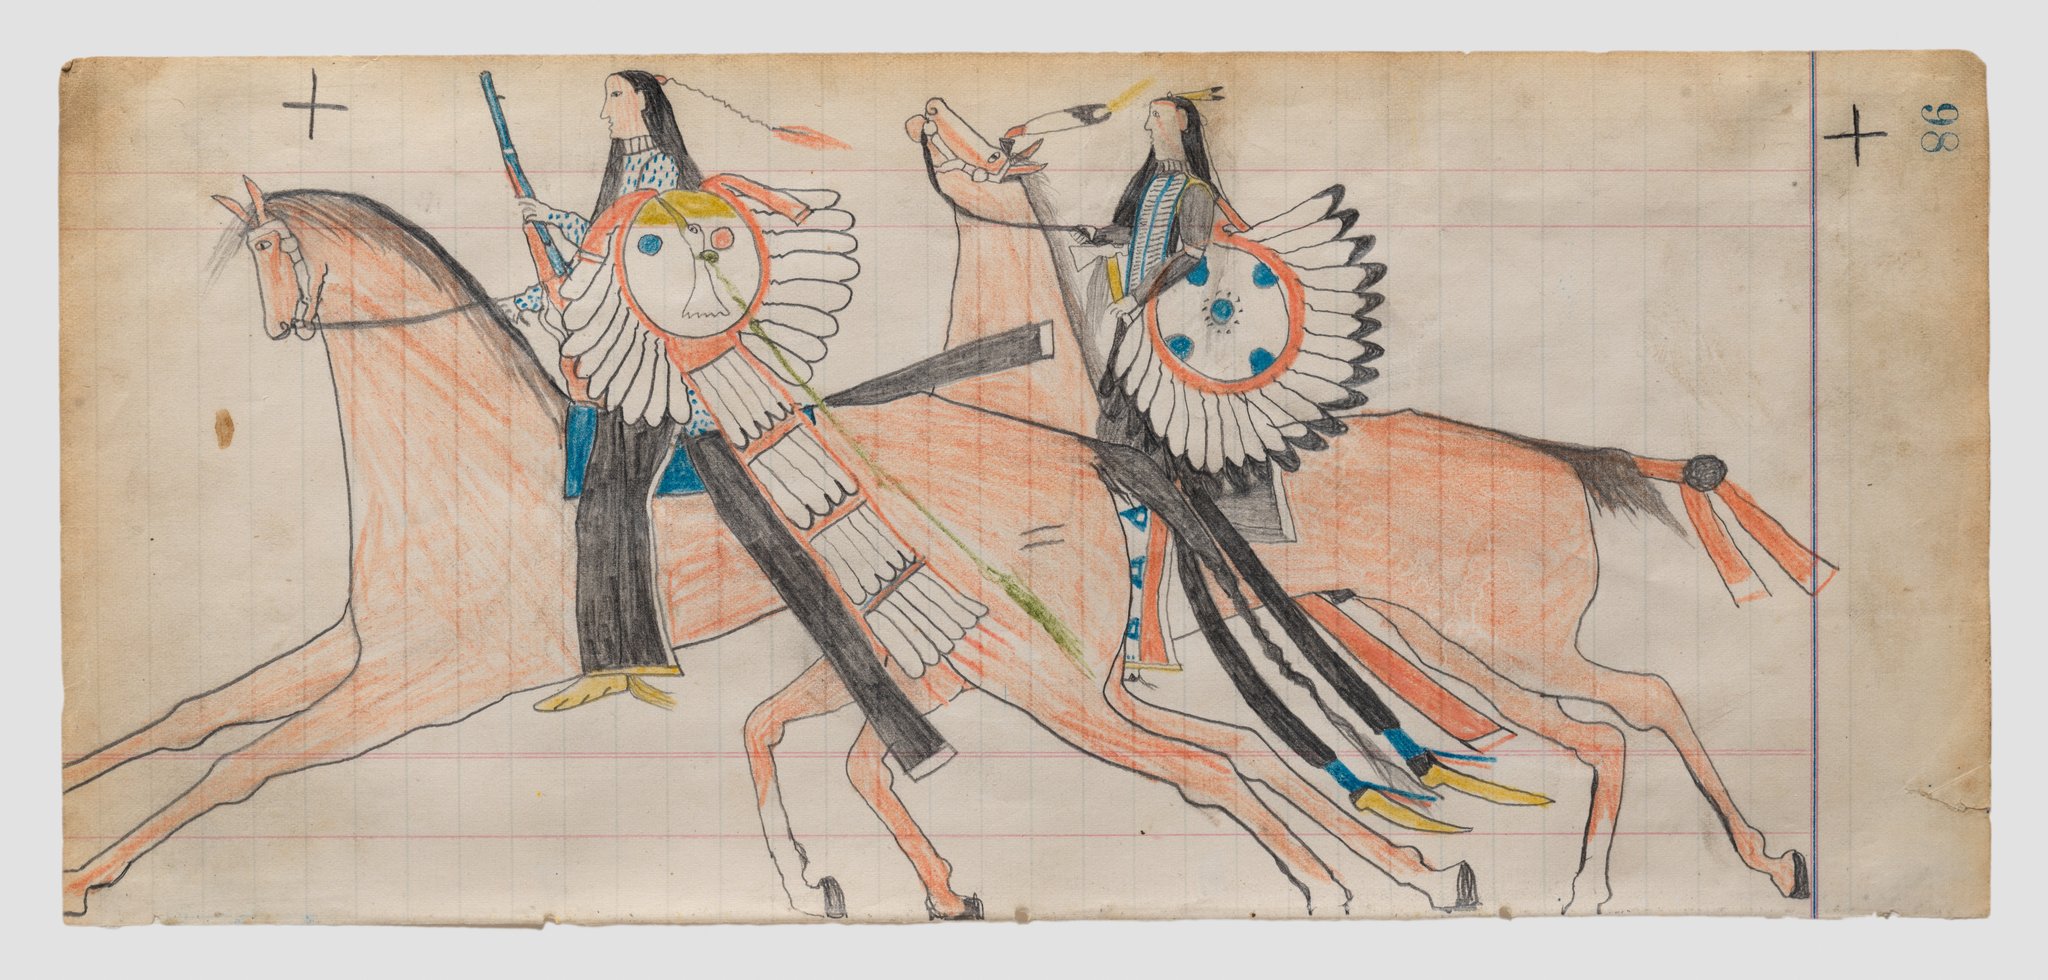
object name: drawing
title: Off to War (Henderson Ledger Artist B)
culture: arapaho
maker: frank henderson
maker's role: artist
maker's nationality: native american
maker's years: 1862-1885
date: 1882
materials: ink, paper, pencil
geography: united states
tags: women,horses